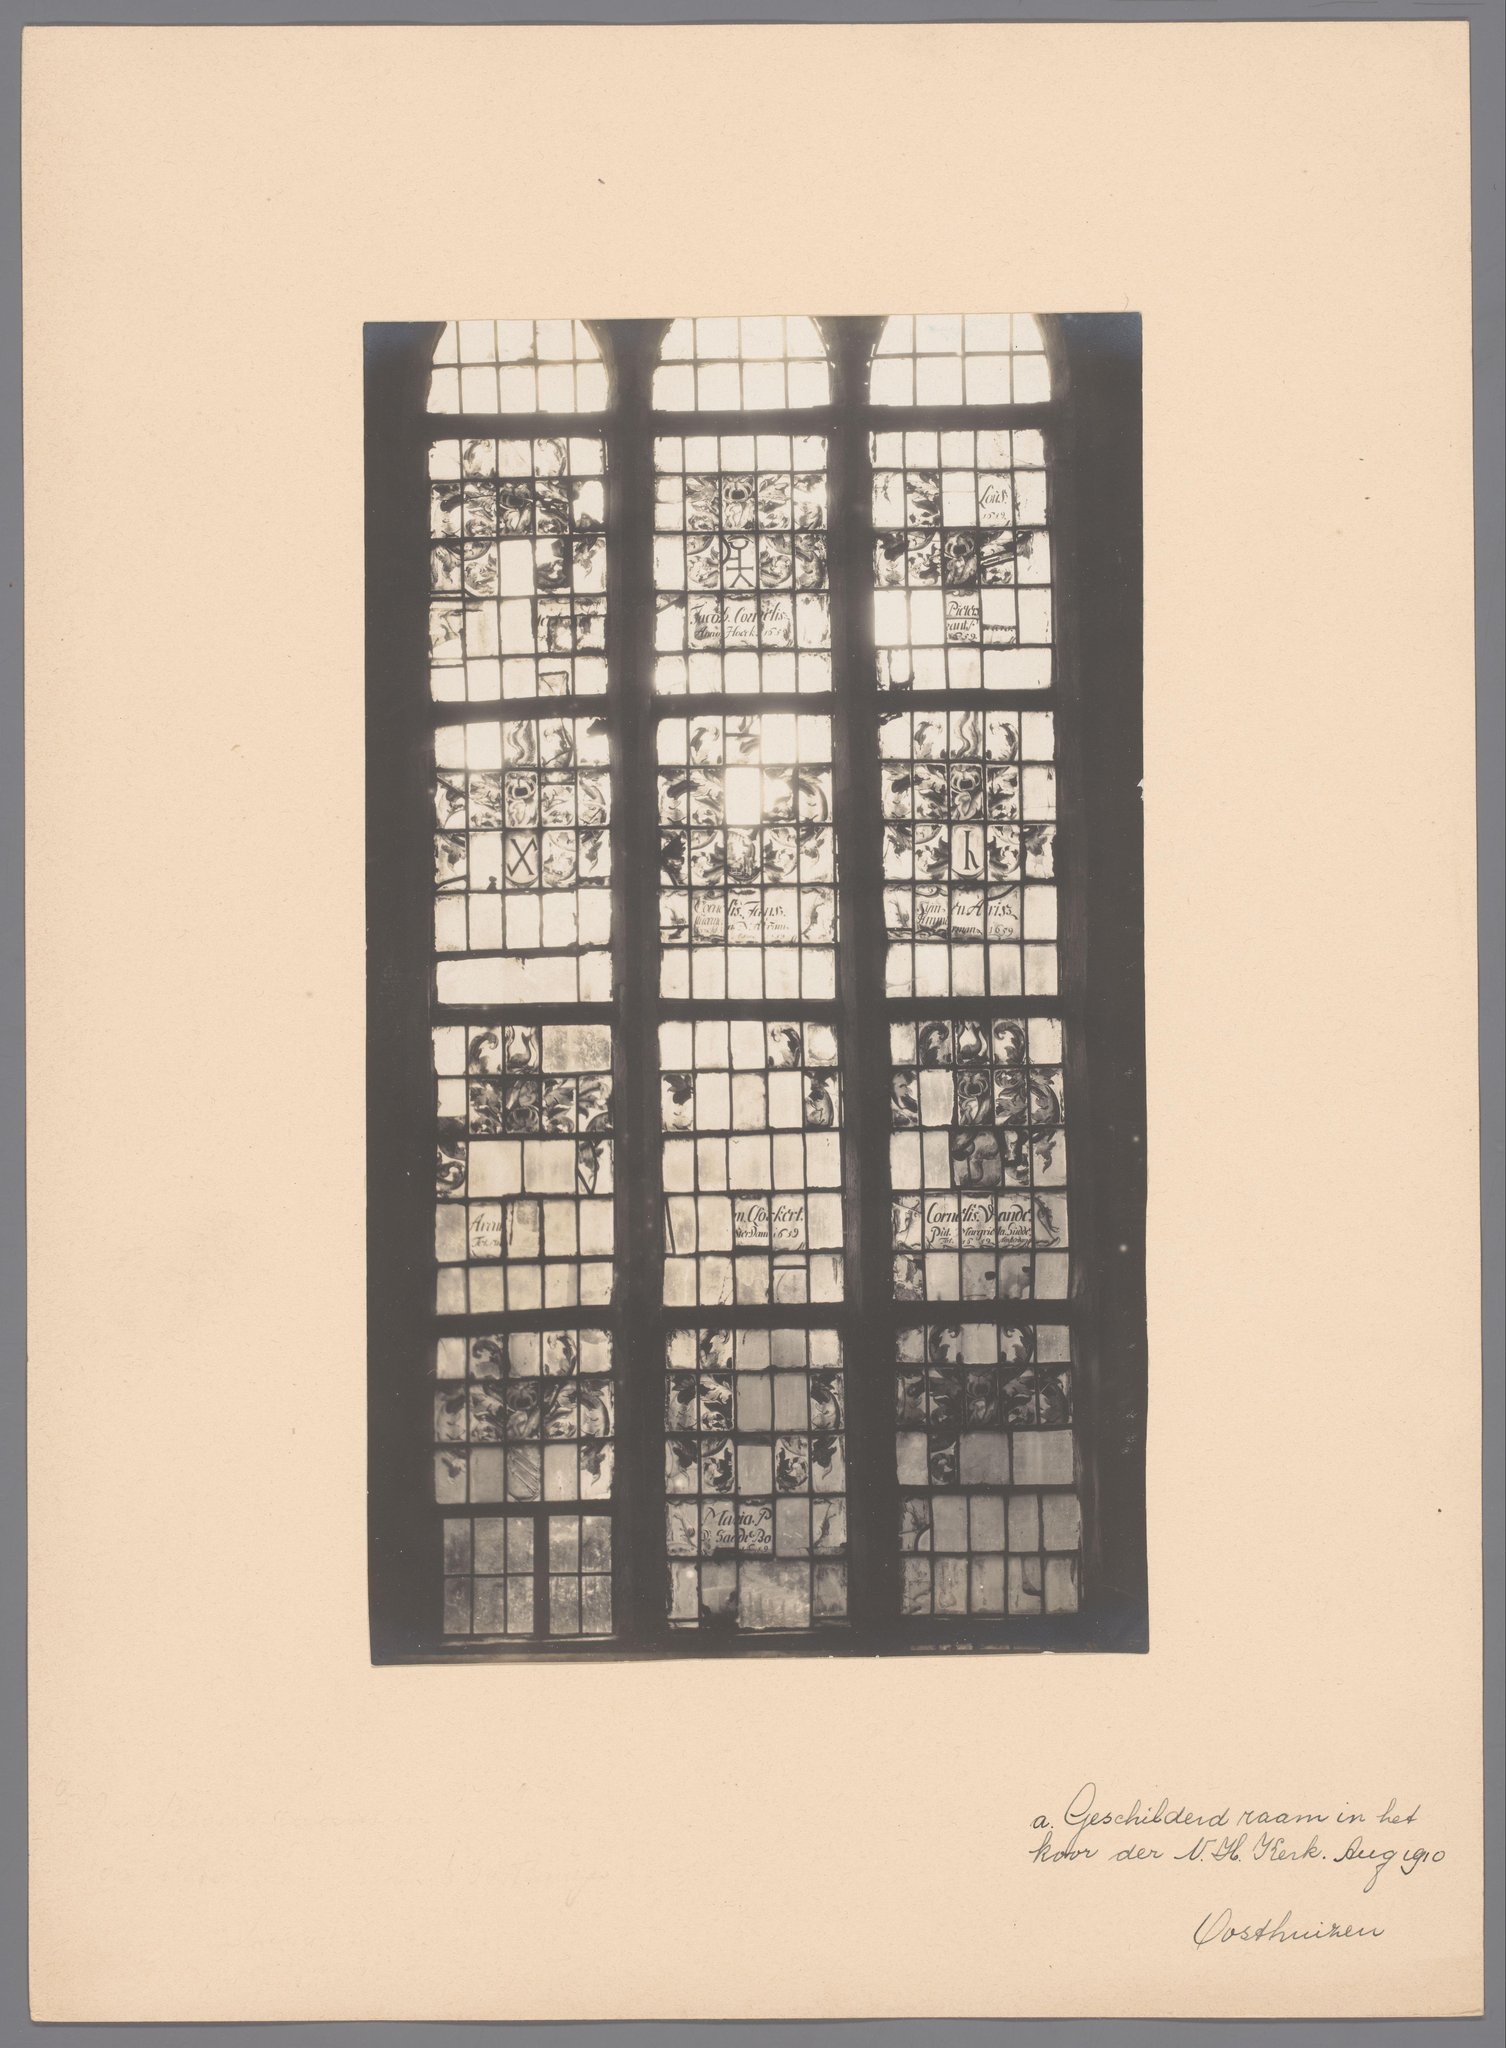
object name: photograph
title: Geschilderd raam in het koor van de Grote Kerk te Oosthuizen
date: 1910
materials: cardboard, photographic support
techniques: gelatin silver print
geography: grote kerk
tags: church-window, e.g. rose-window, interior of church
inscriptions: annotation: ‘a. Geschilderd raam in het koor der N.H. Kerk. Aug 1910/ Oosthuizen’